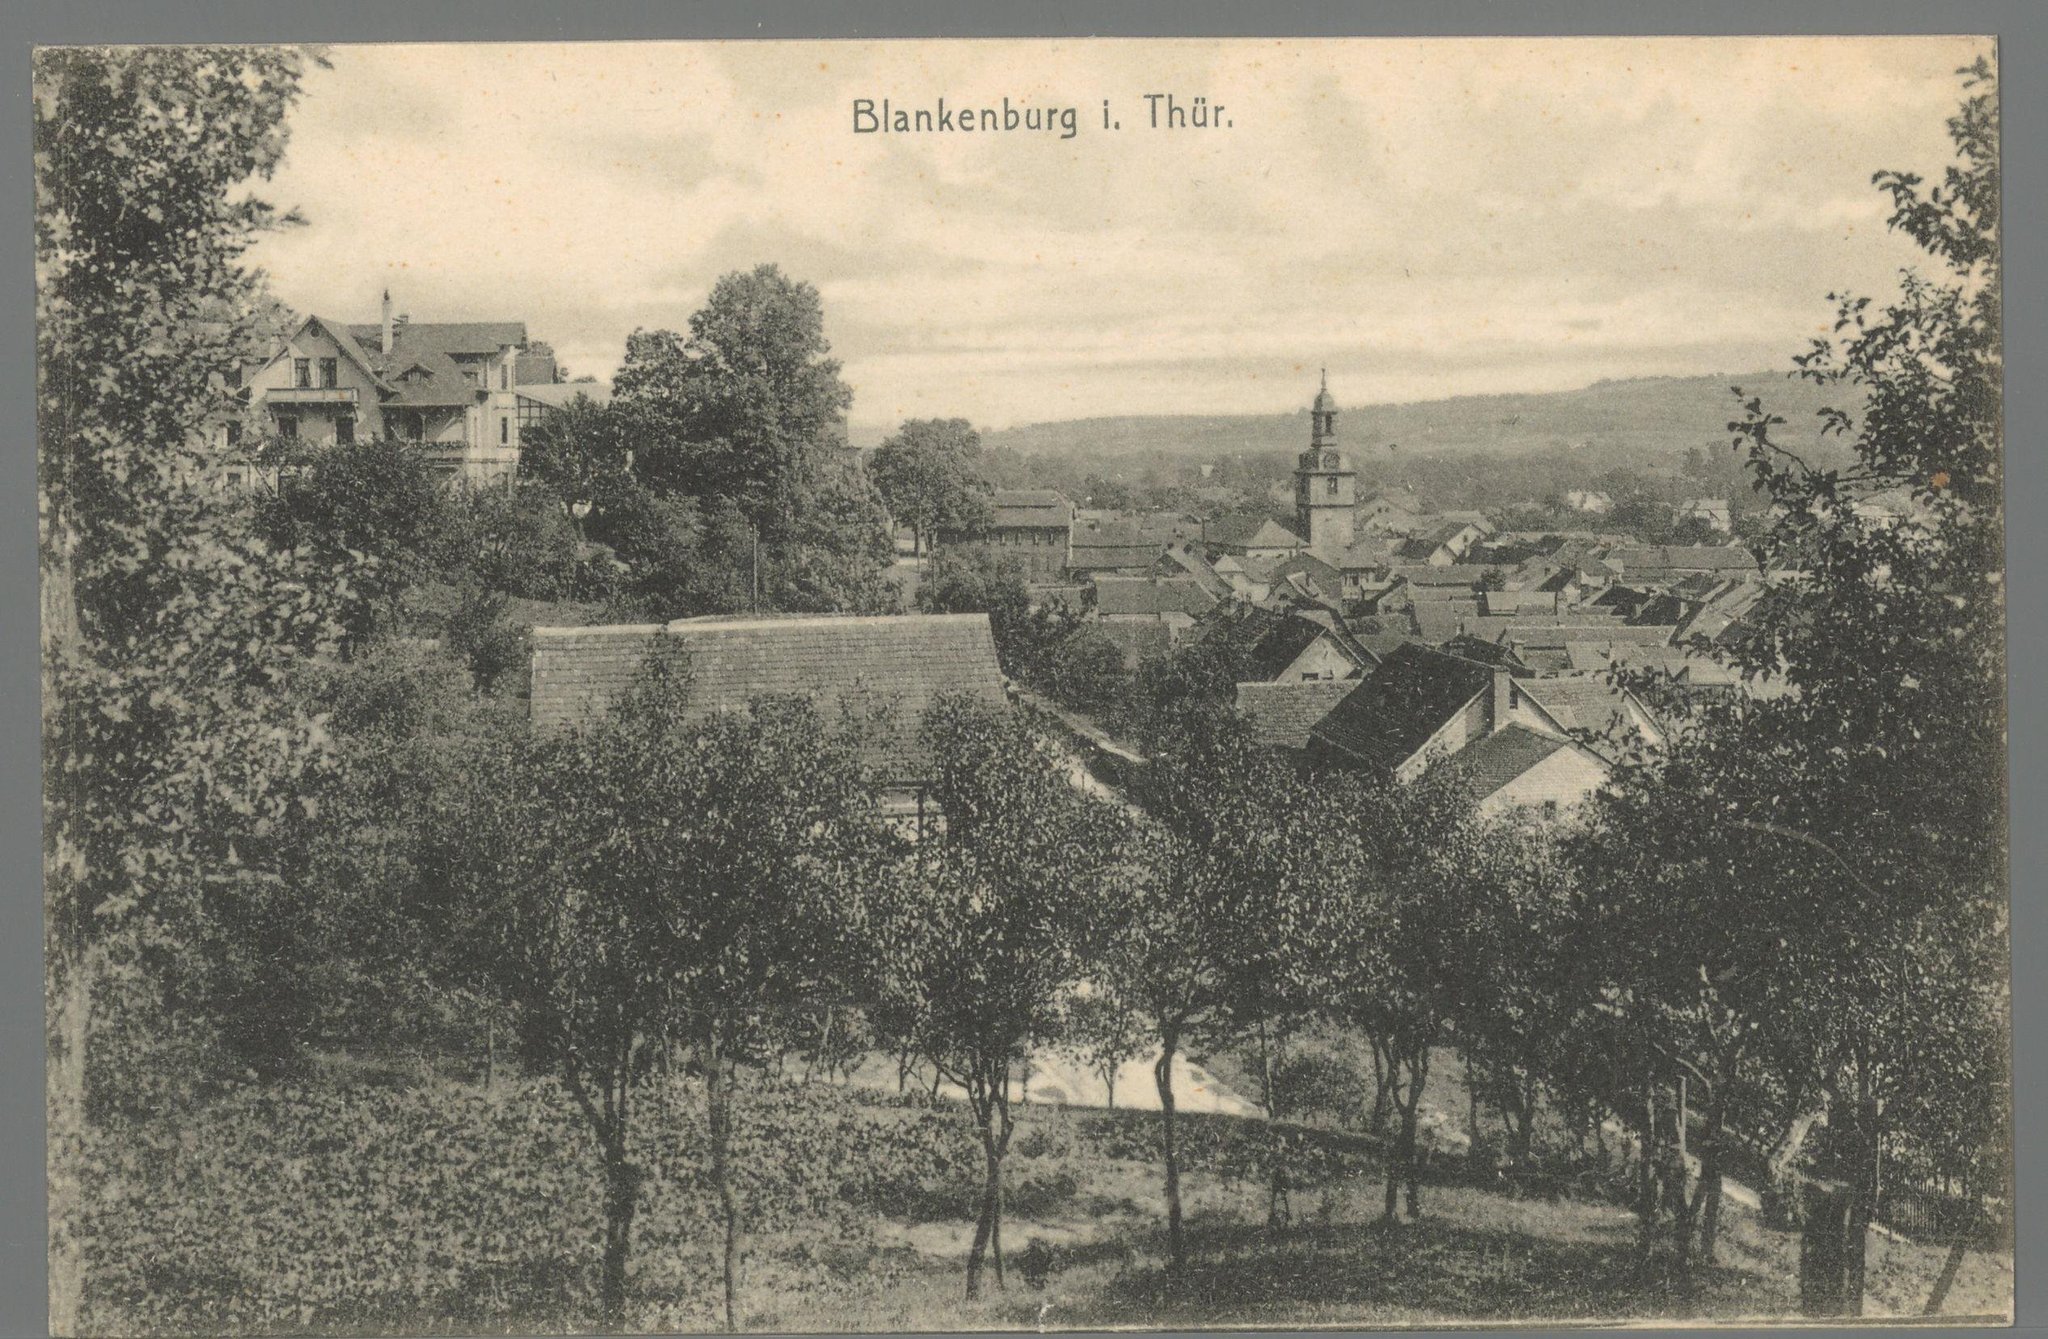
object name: ansichtkaart, prentbriefkaart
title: Blankenburg i. Thür.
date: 1909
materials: cardboard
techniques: photograph, writing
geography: leipzig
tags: city-view, and landscape with man-made constructions, church (exterior)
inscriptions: date